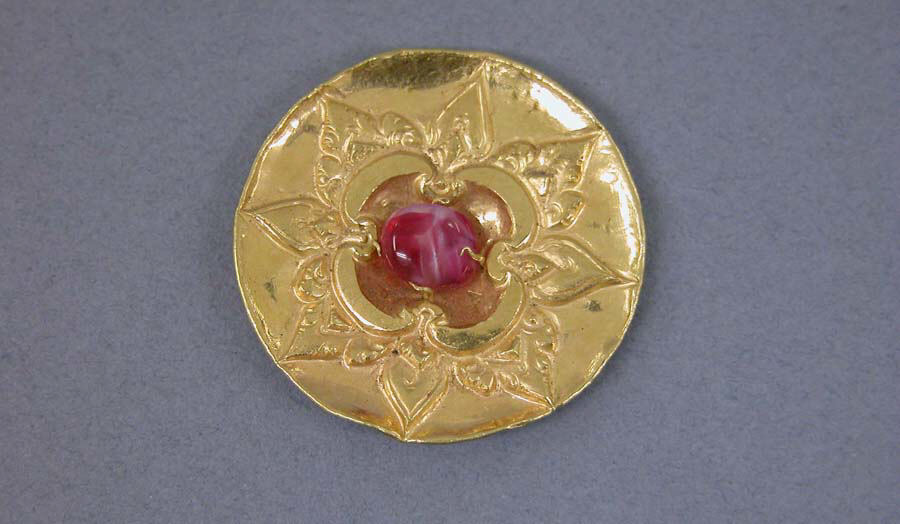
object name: ear plug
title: Subang (Ear Plug) with Foliate Design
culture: indonesian, javanese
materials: gold